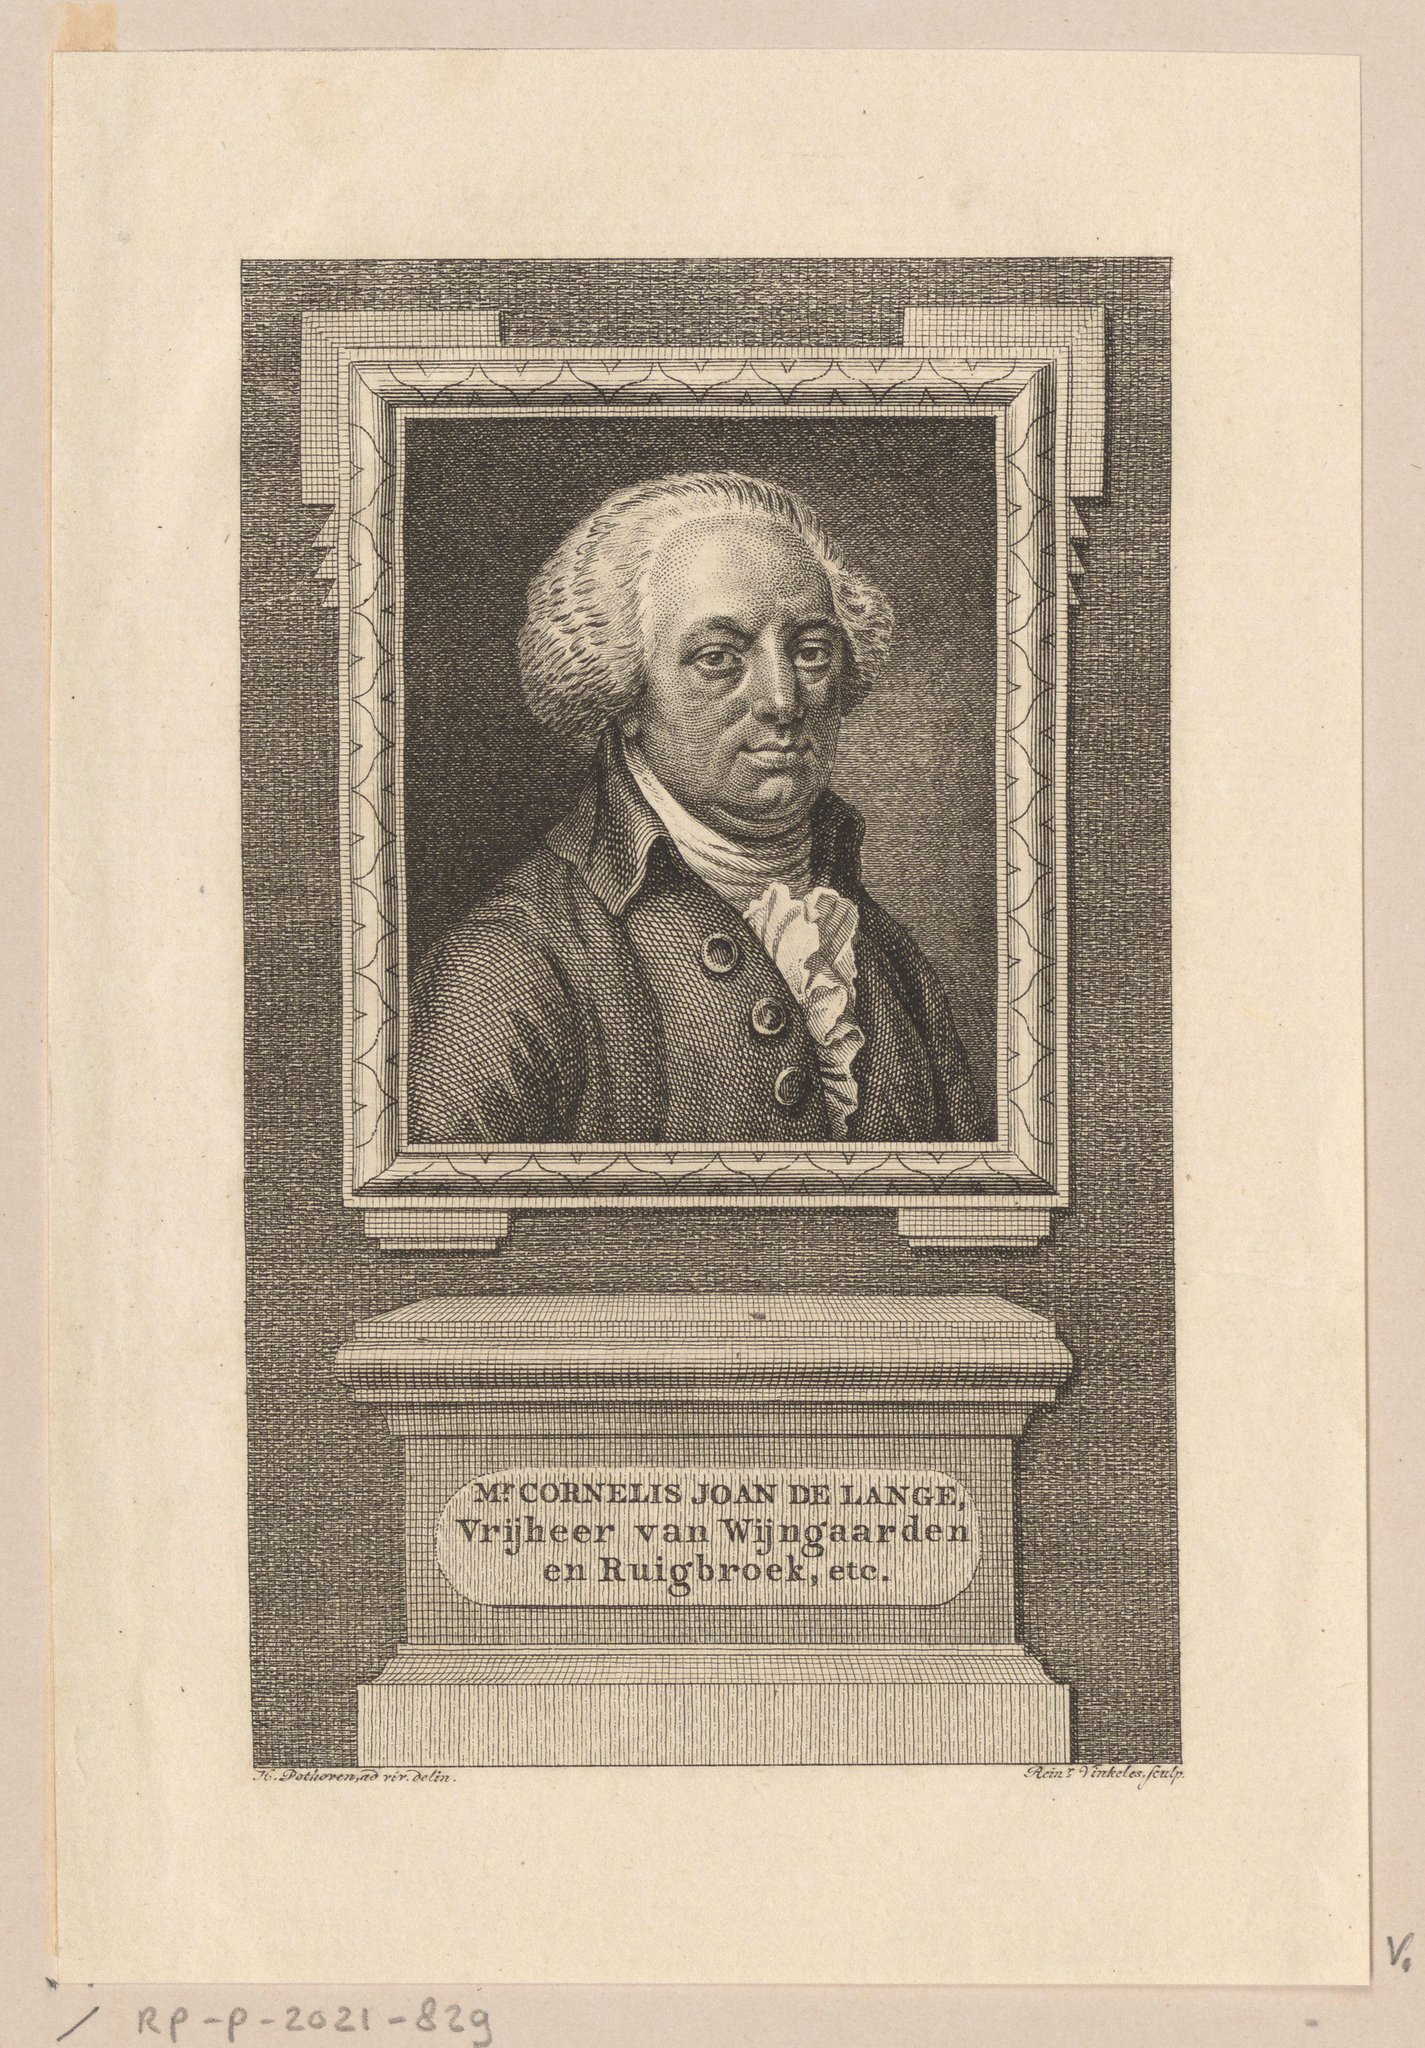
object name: book illustration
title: Portret van Cornelis Johan de Lange van Wijngaarden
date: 1786-1811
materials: paper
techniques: etching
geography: amsterdam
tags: gouda, history and archaeology (+ portrait of scholar, scientist), historical persons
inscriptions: collector's mark: Lugt 2166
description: Prent waarschijnlijk uit: Loosjes, Petrus. Vaderlandsche historie (...) ten vervolge van Wagenaars Historie. 48 dln. Amsterdam: Johannes Allart, 1786-1811, dl. 10. Of uit een latere druk.